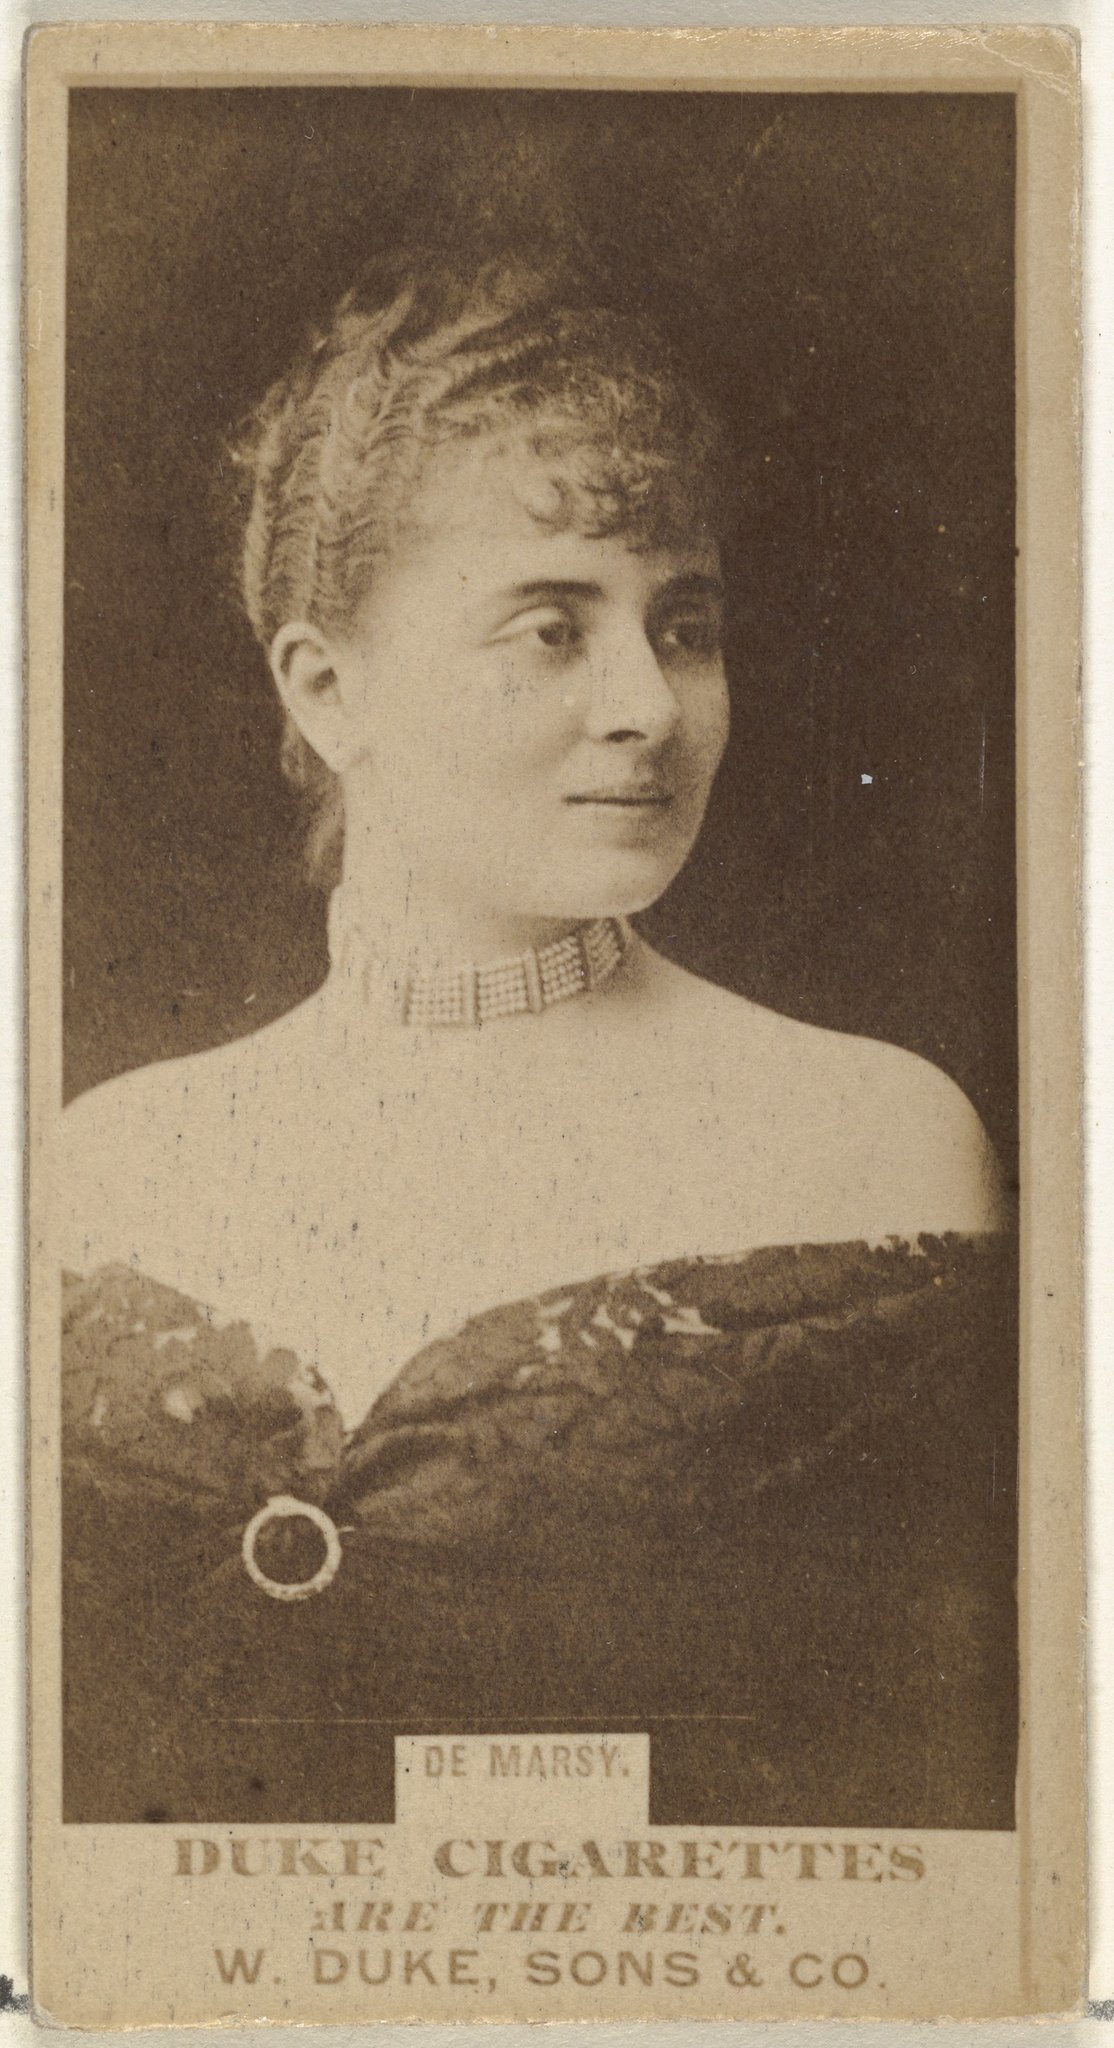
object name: photograph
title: De Marsy, from the Actors and Actresses series (N145-7) issued by Duke Sons & Co. to promote Duke Cigarettes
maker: w. duke, sons & co.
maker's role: publisher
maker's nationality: american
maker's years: 1870-1920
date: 1880-1889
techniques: albumen silver print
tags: portraits,women,actresses